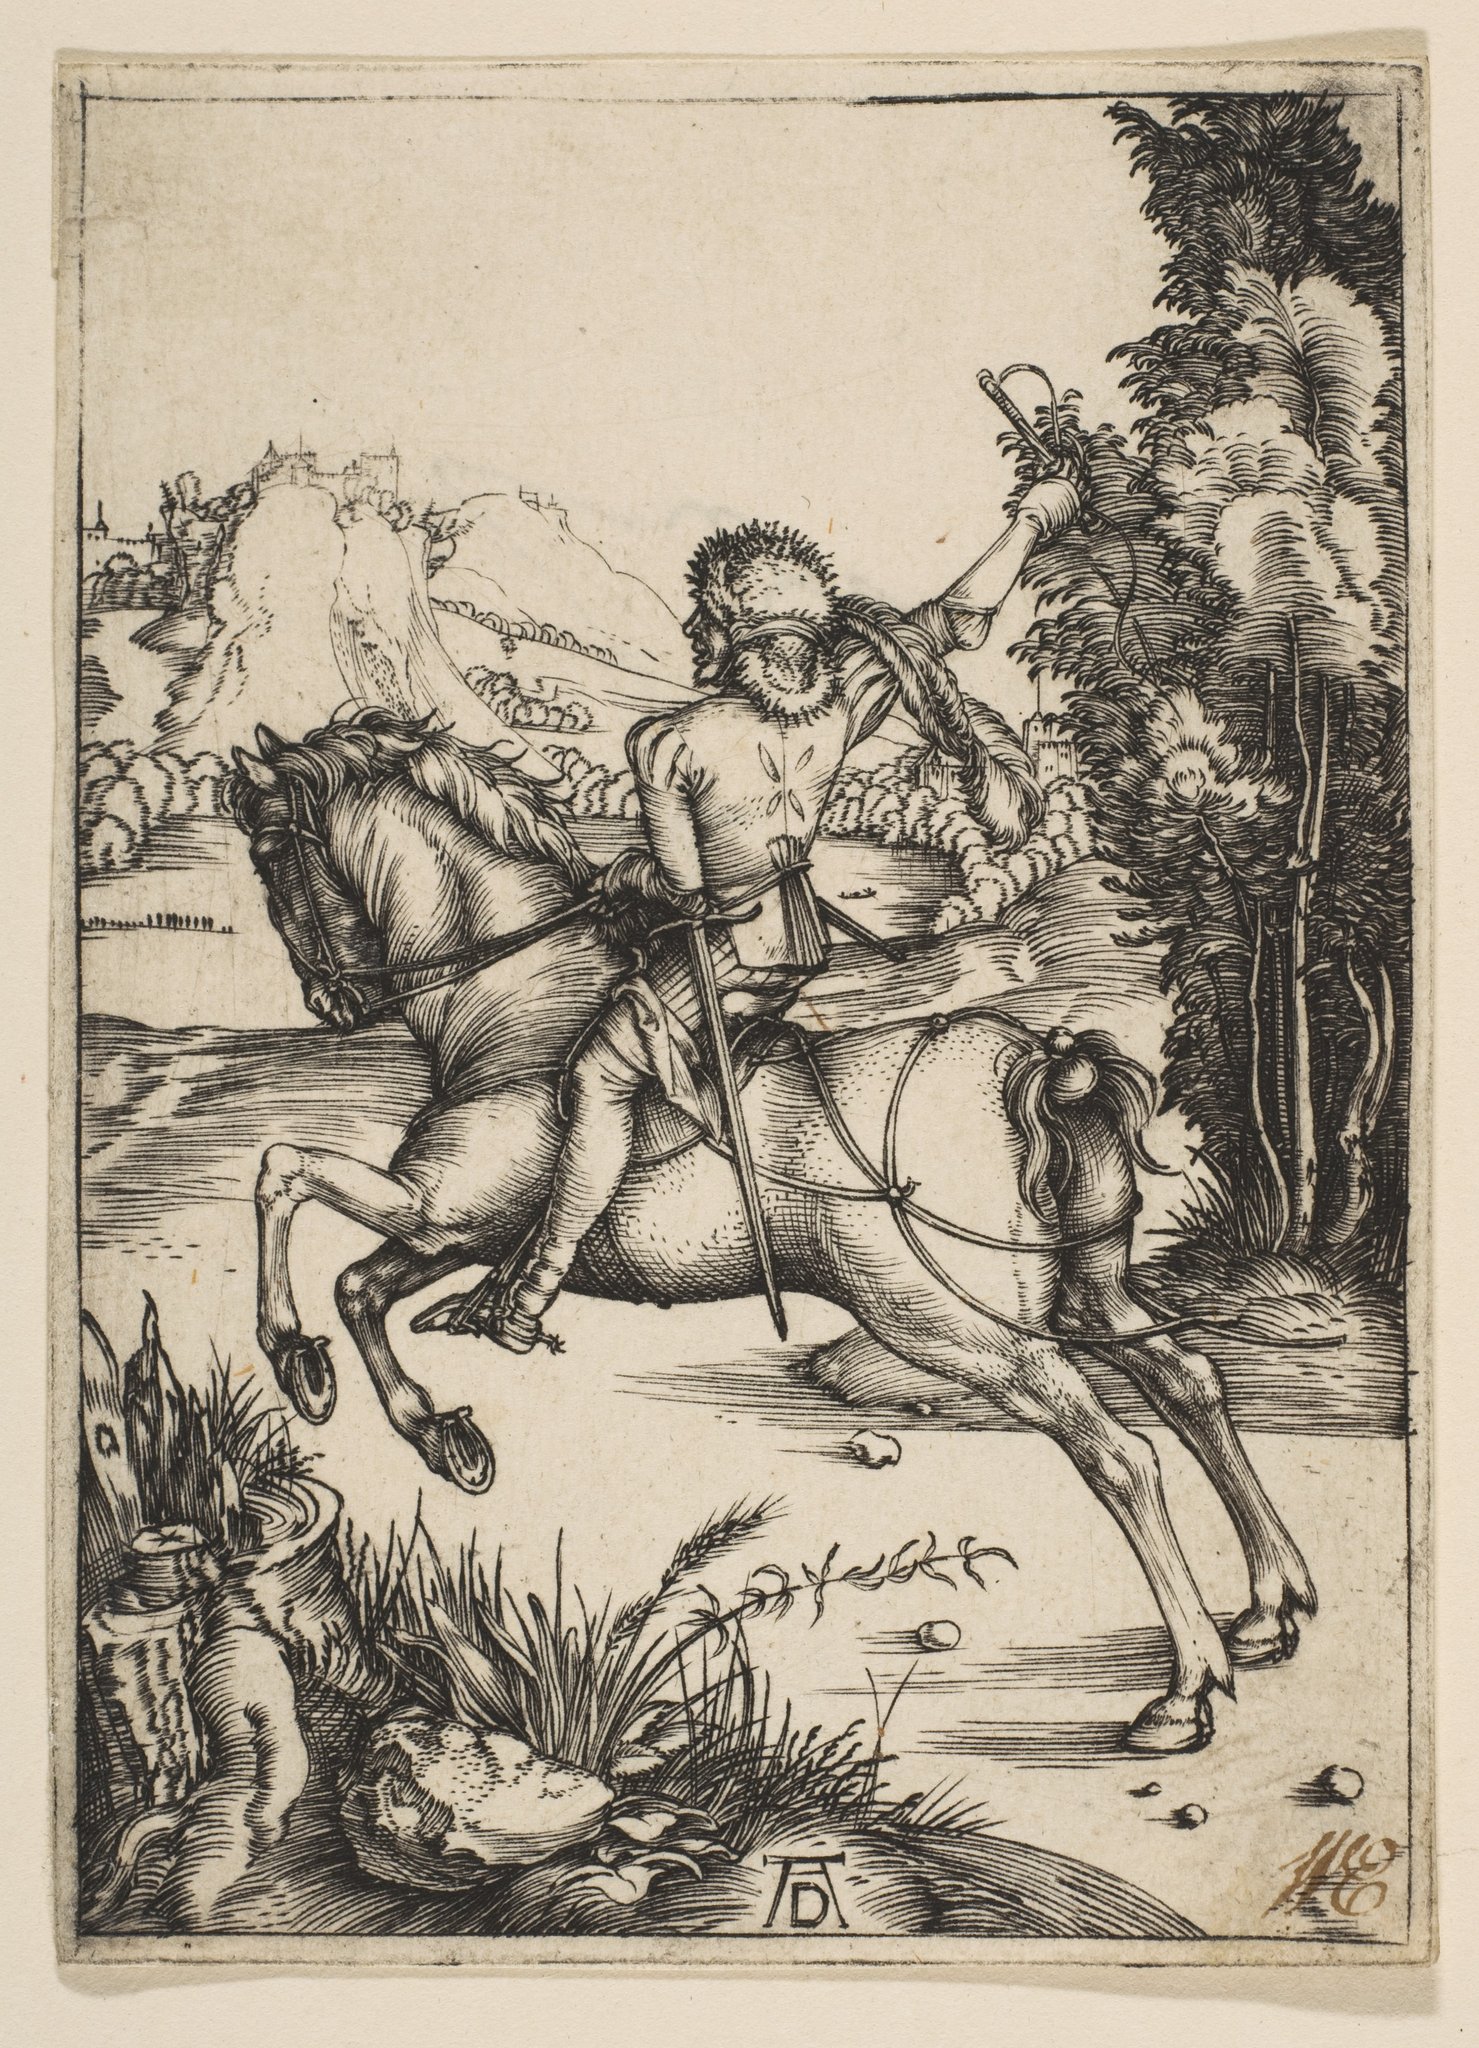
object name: print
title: The Little Courier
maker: albrecht dürer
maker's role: artist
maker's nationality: german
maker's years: 1471-1528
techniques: engraving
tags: human figures,swords,horses